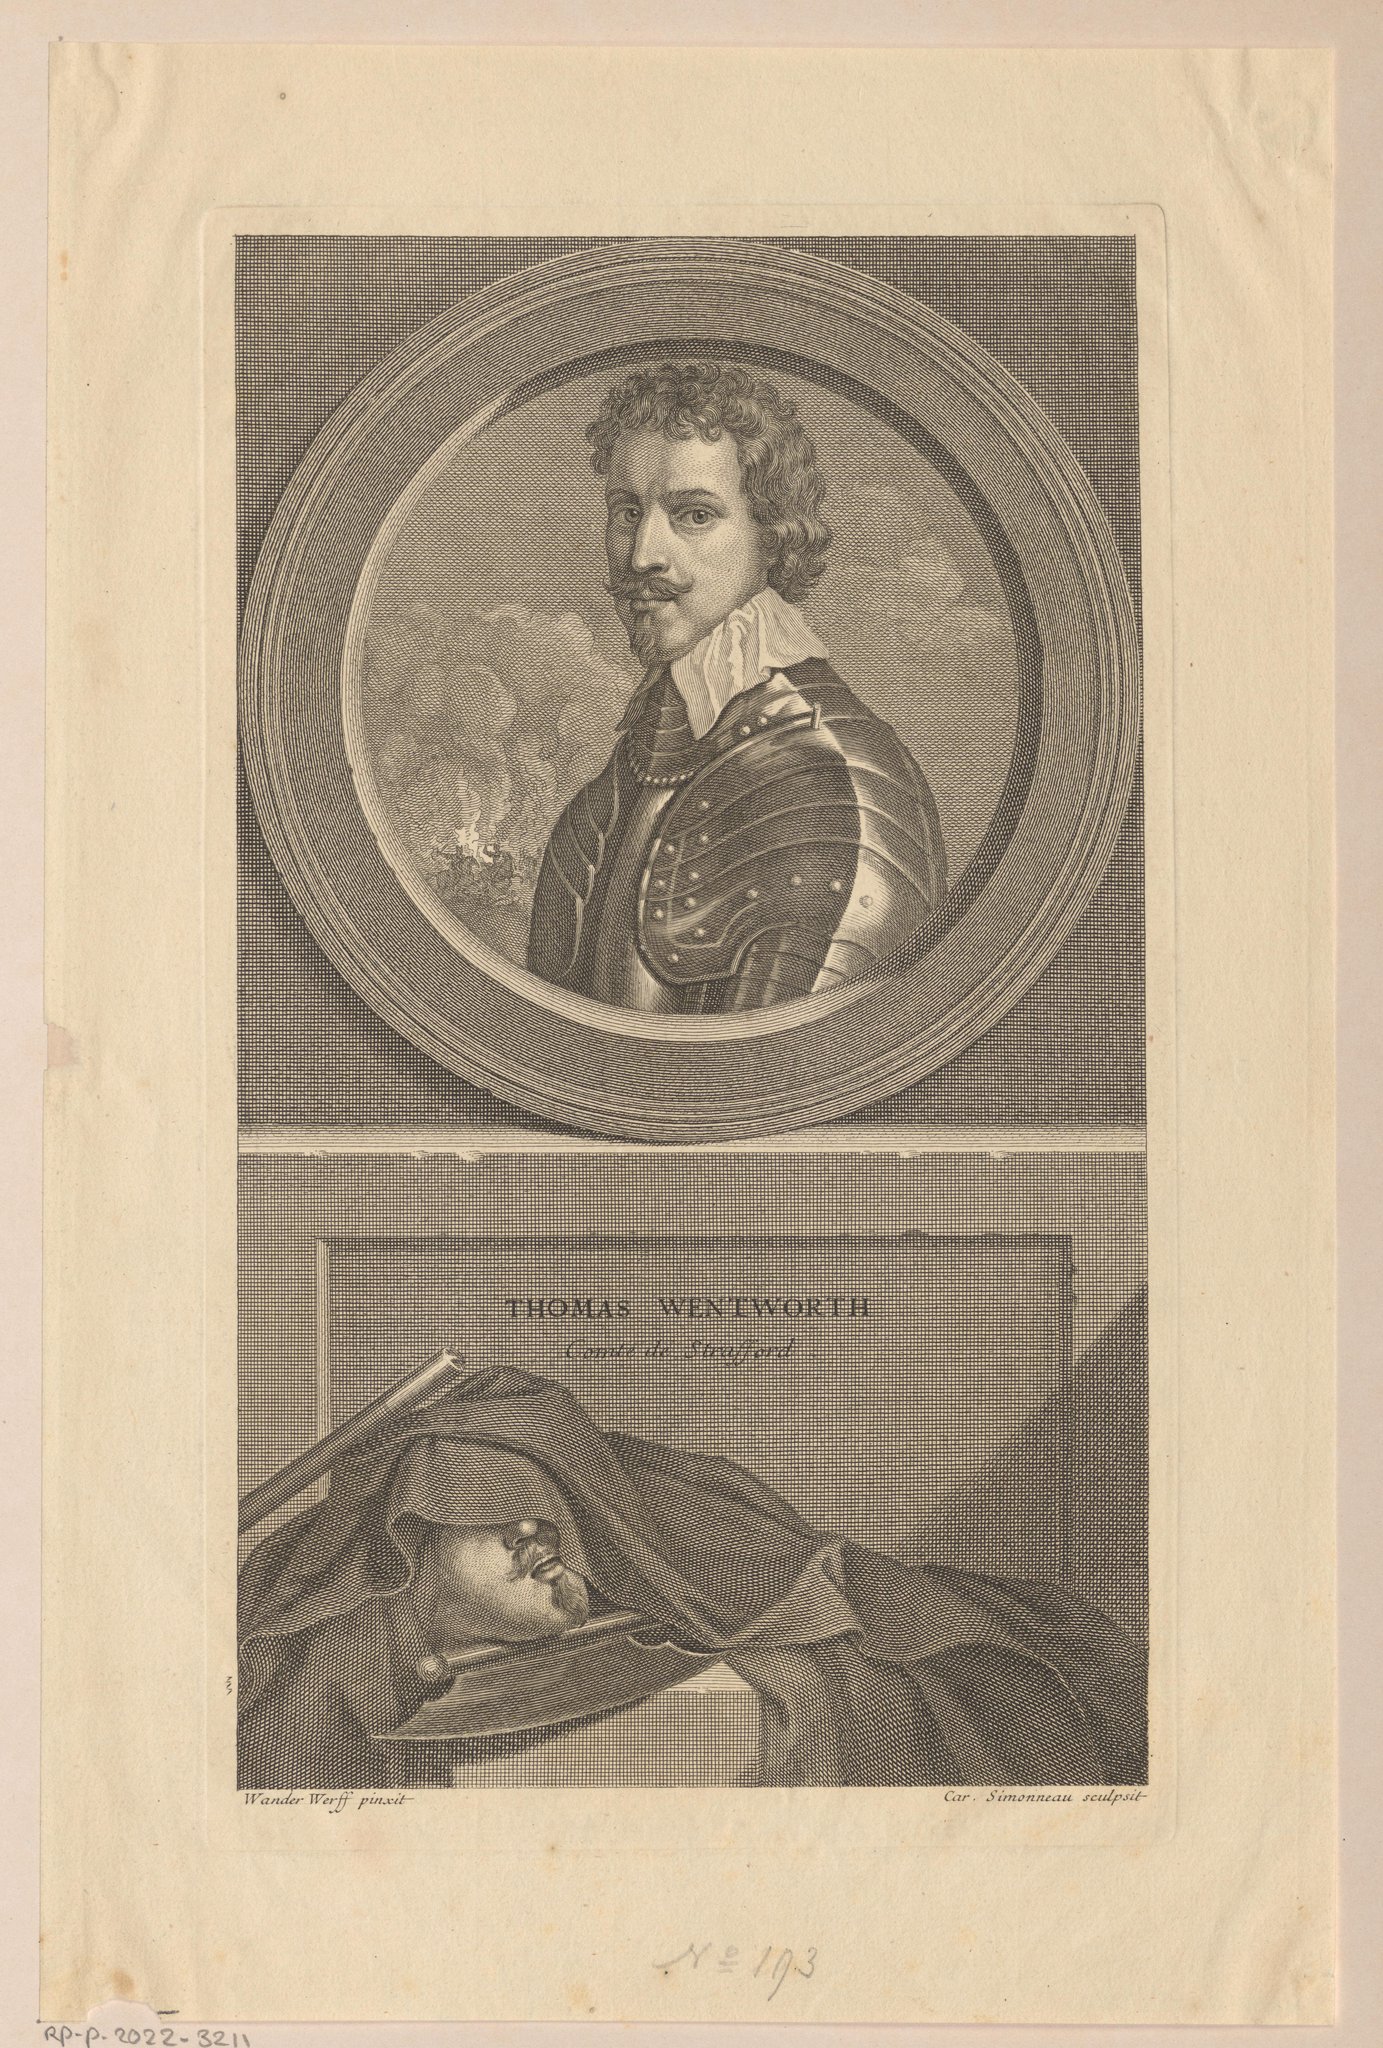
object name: print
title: Portret van Thomas Wentworth, eerste graaf van Strafford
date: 1655-1728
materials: paper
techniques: engraving, etching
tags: london, politician, historical persons, other sovereign (with title), politician, e.g. party leader